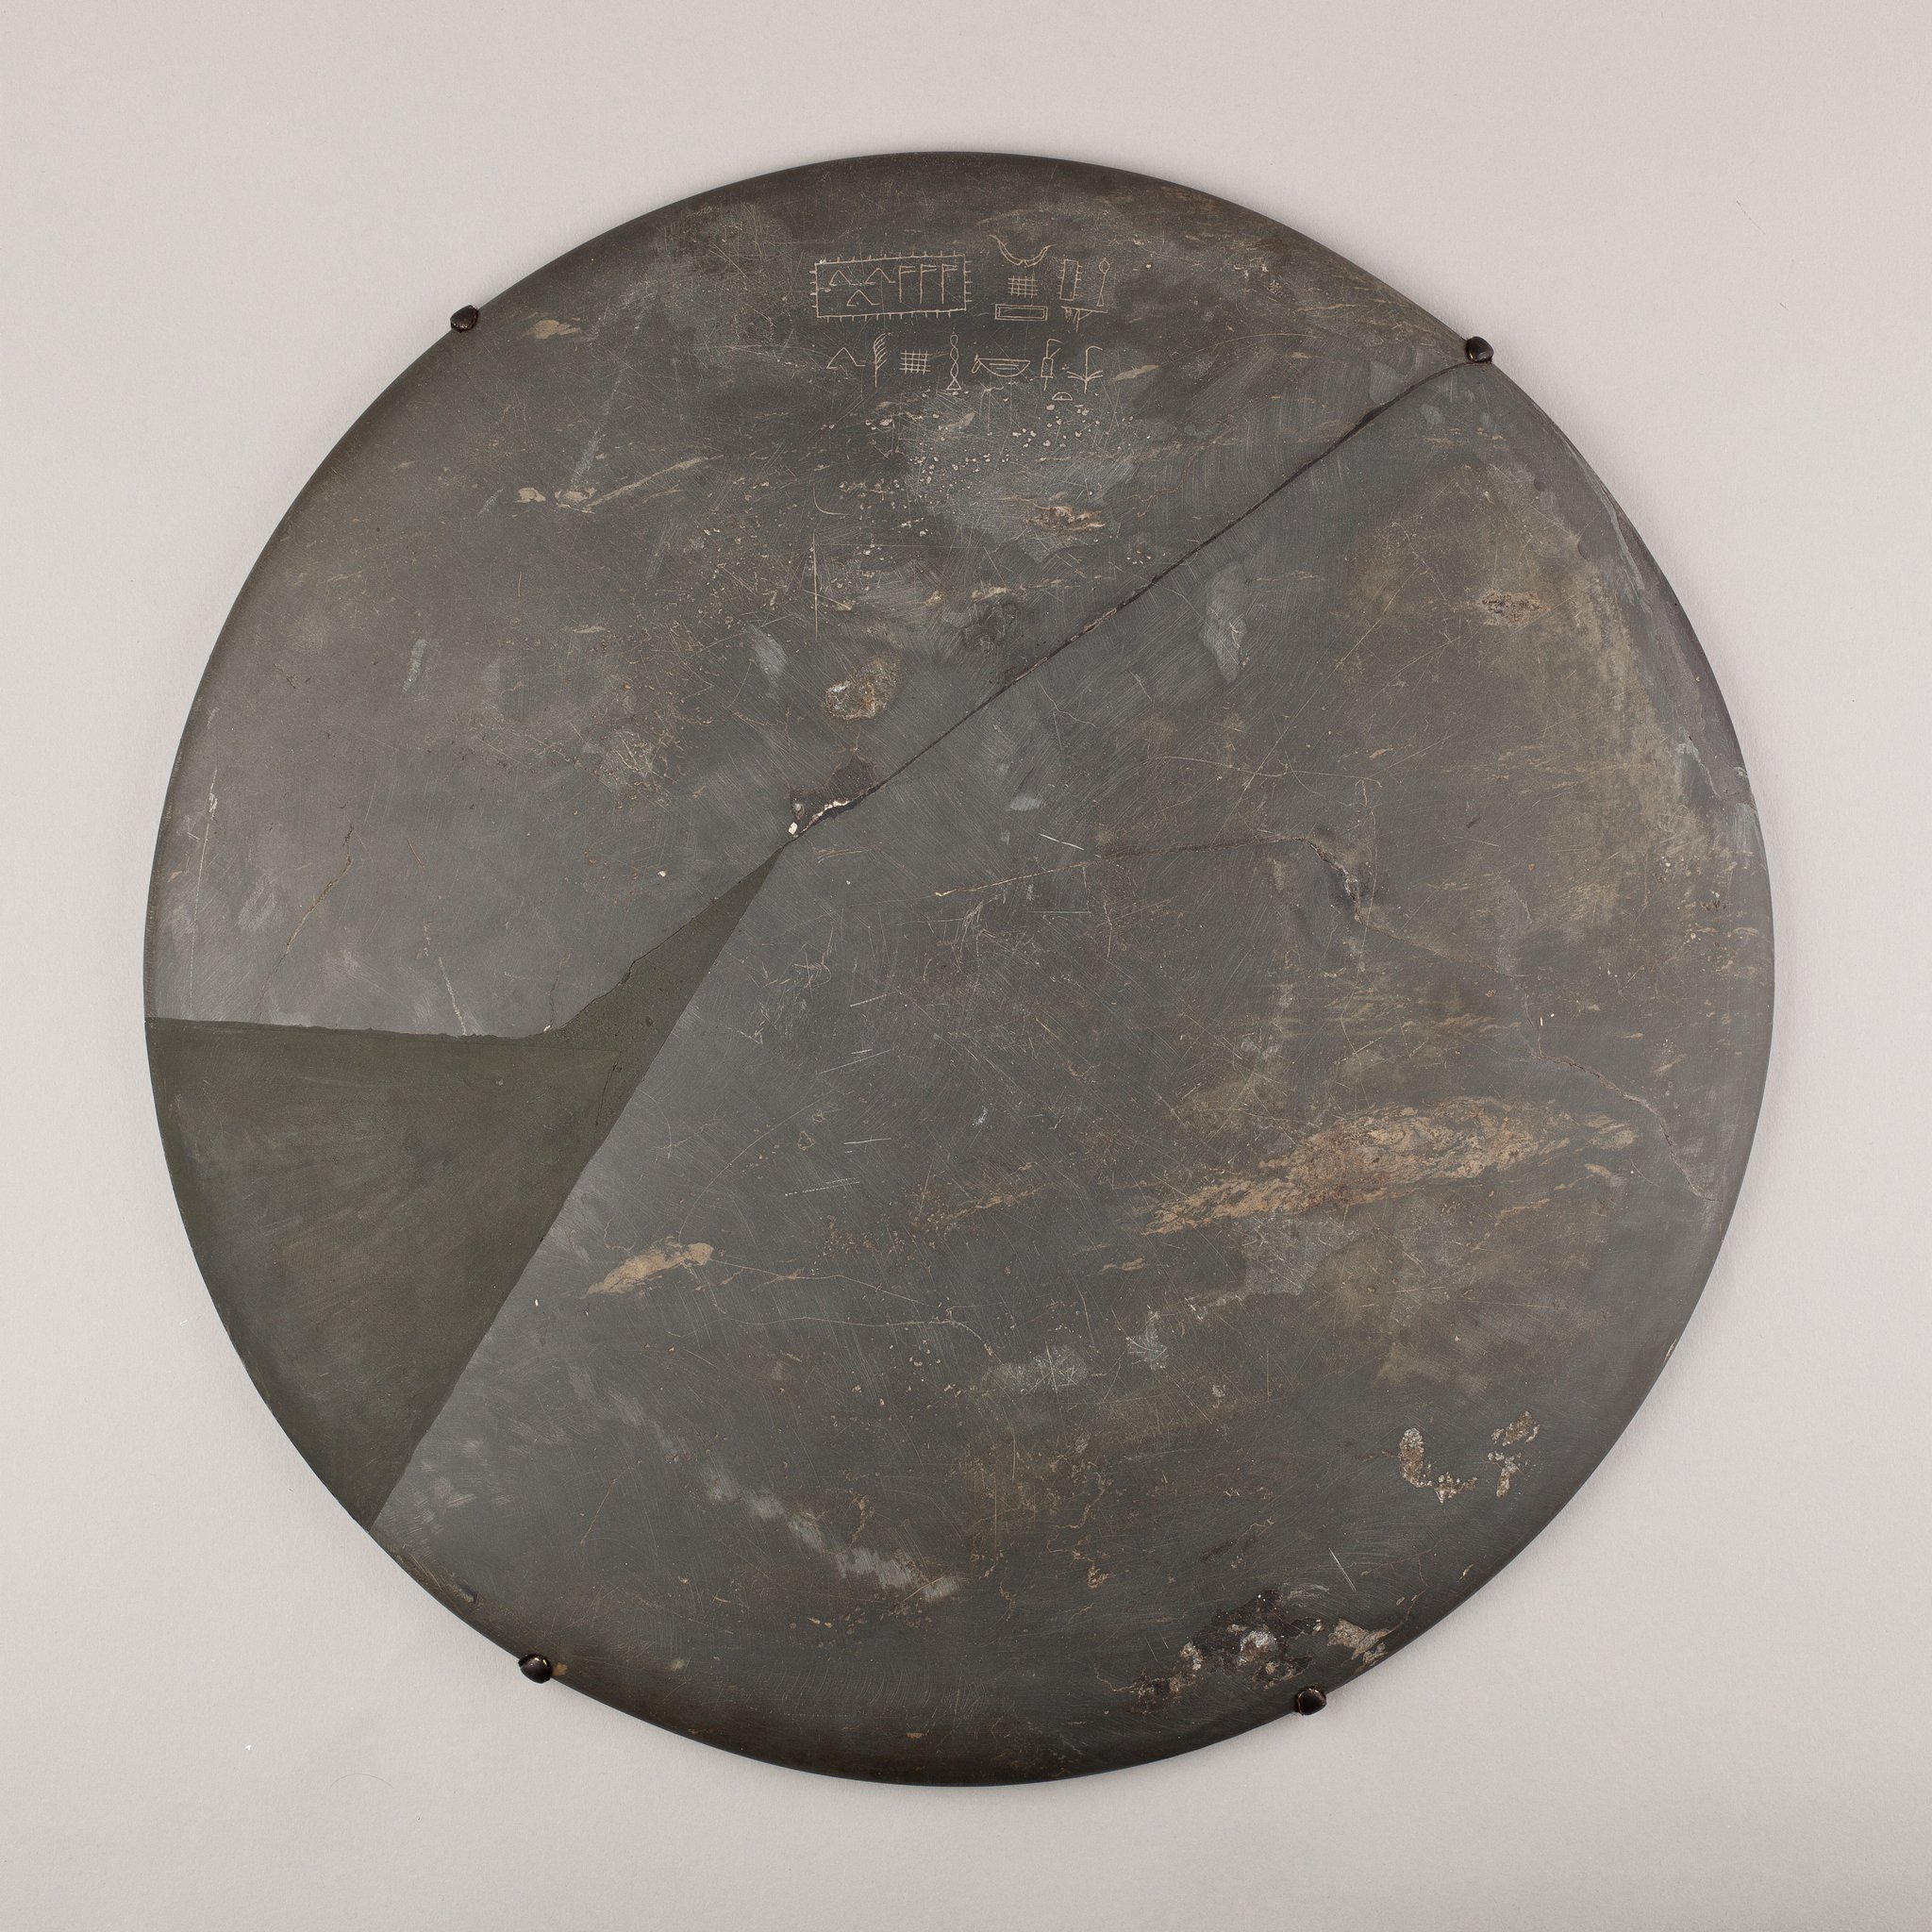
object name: dish, ritual event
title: Dish with an inscription recording a ritual event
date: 3100-2650 BCE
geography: egypt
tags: hieroglyphs